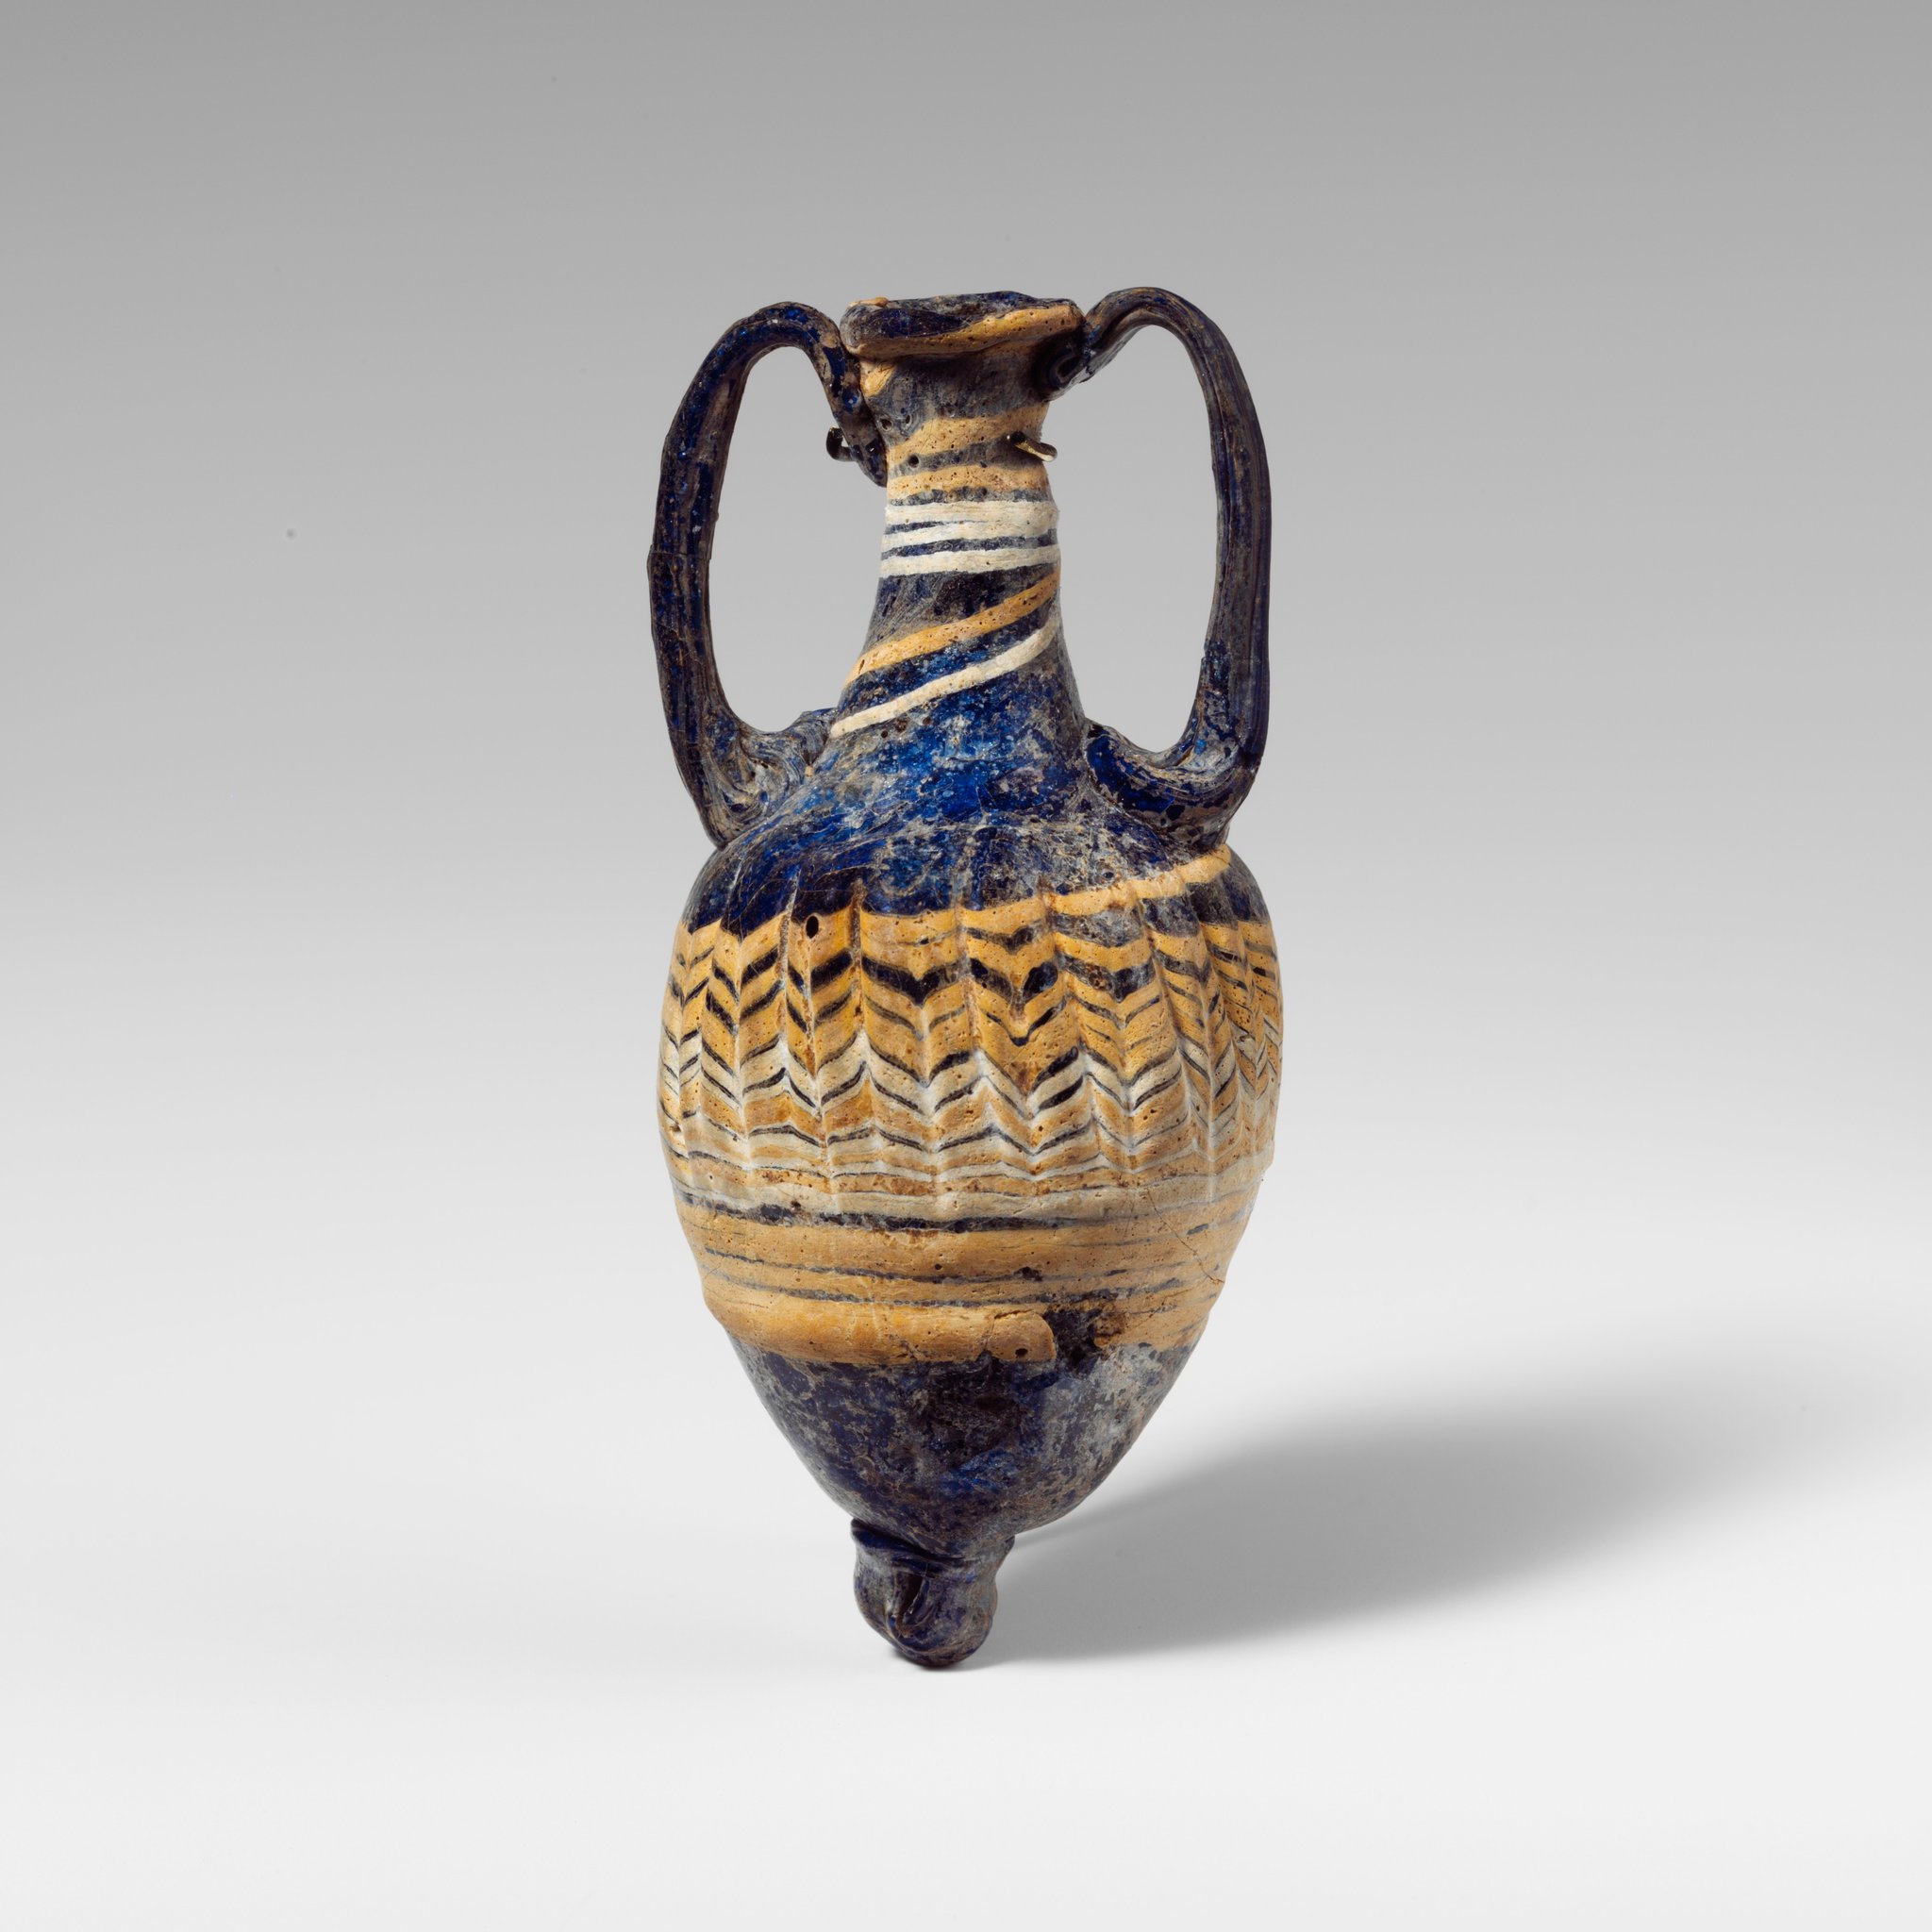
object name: amphoriskos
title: Glass amphoriskos (perfume bottle)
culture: greek or eastern mediterranean or italian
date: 300-201 BCE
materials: glass